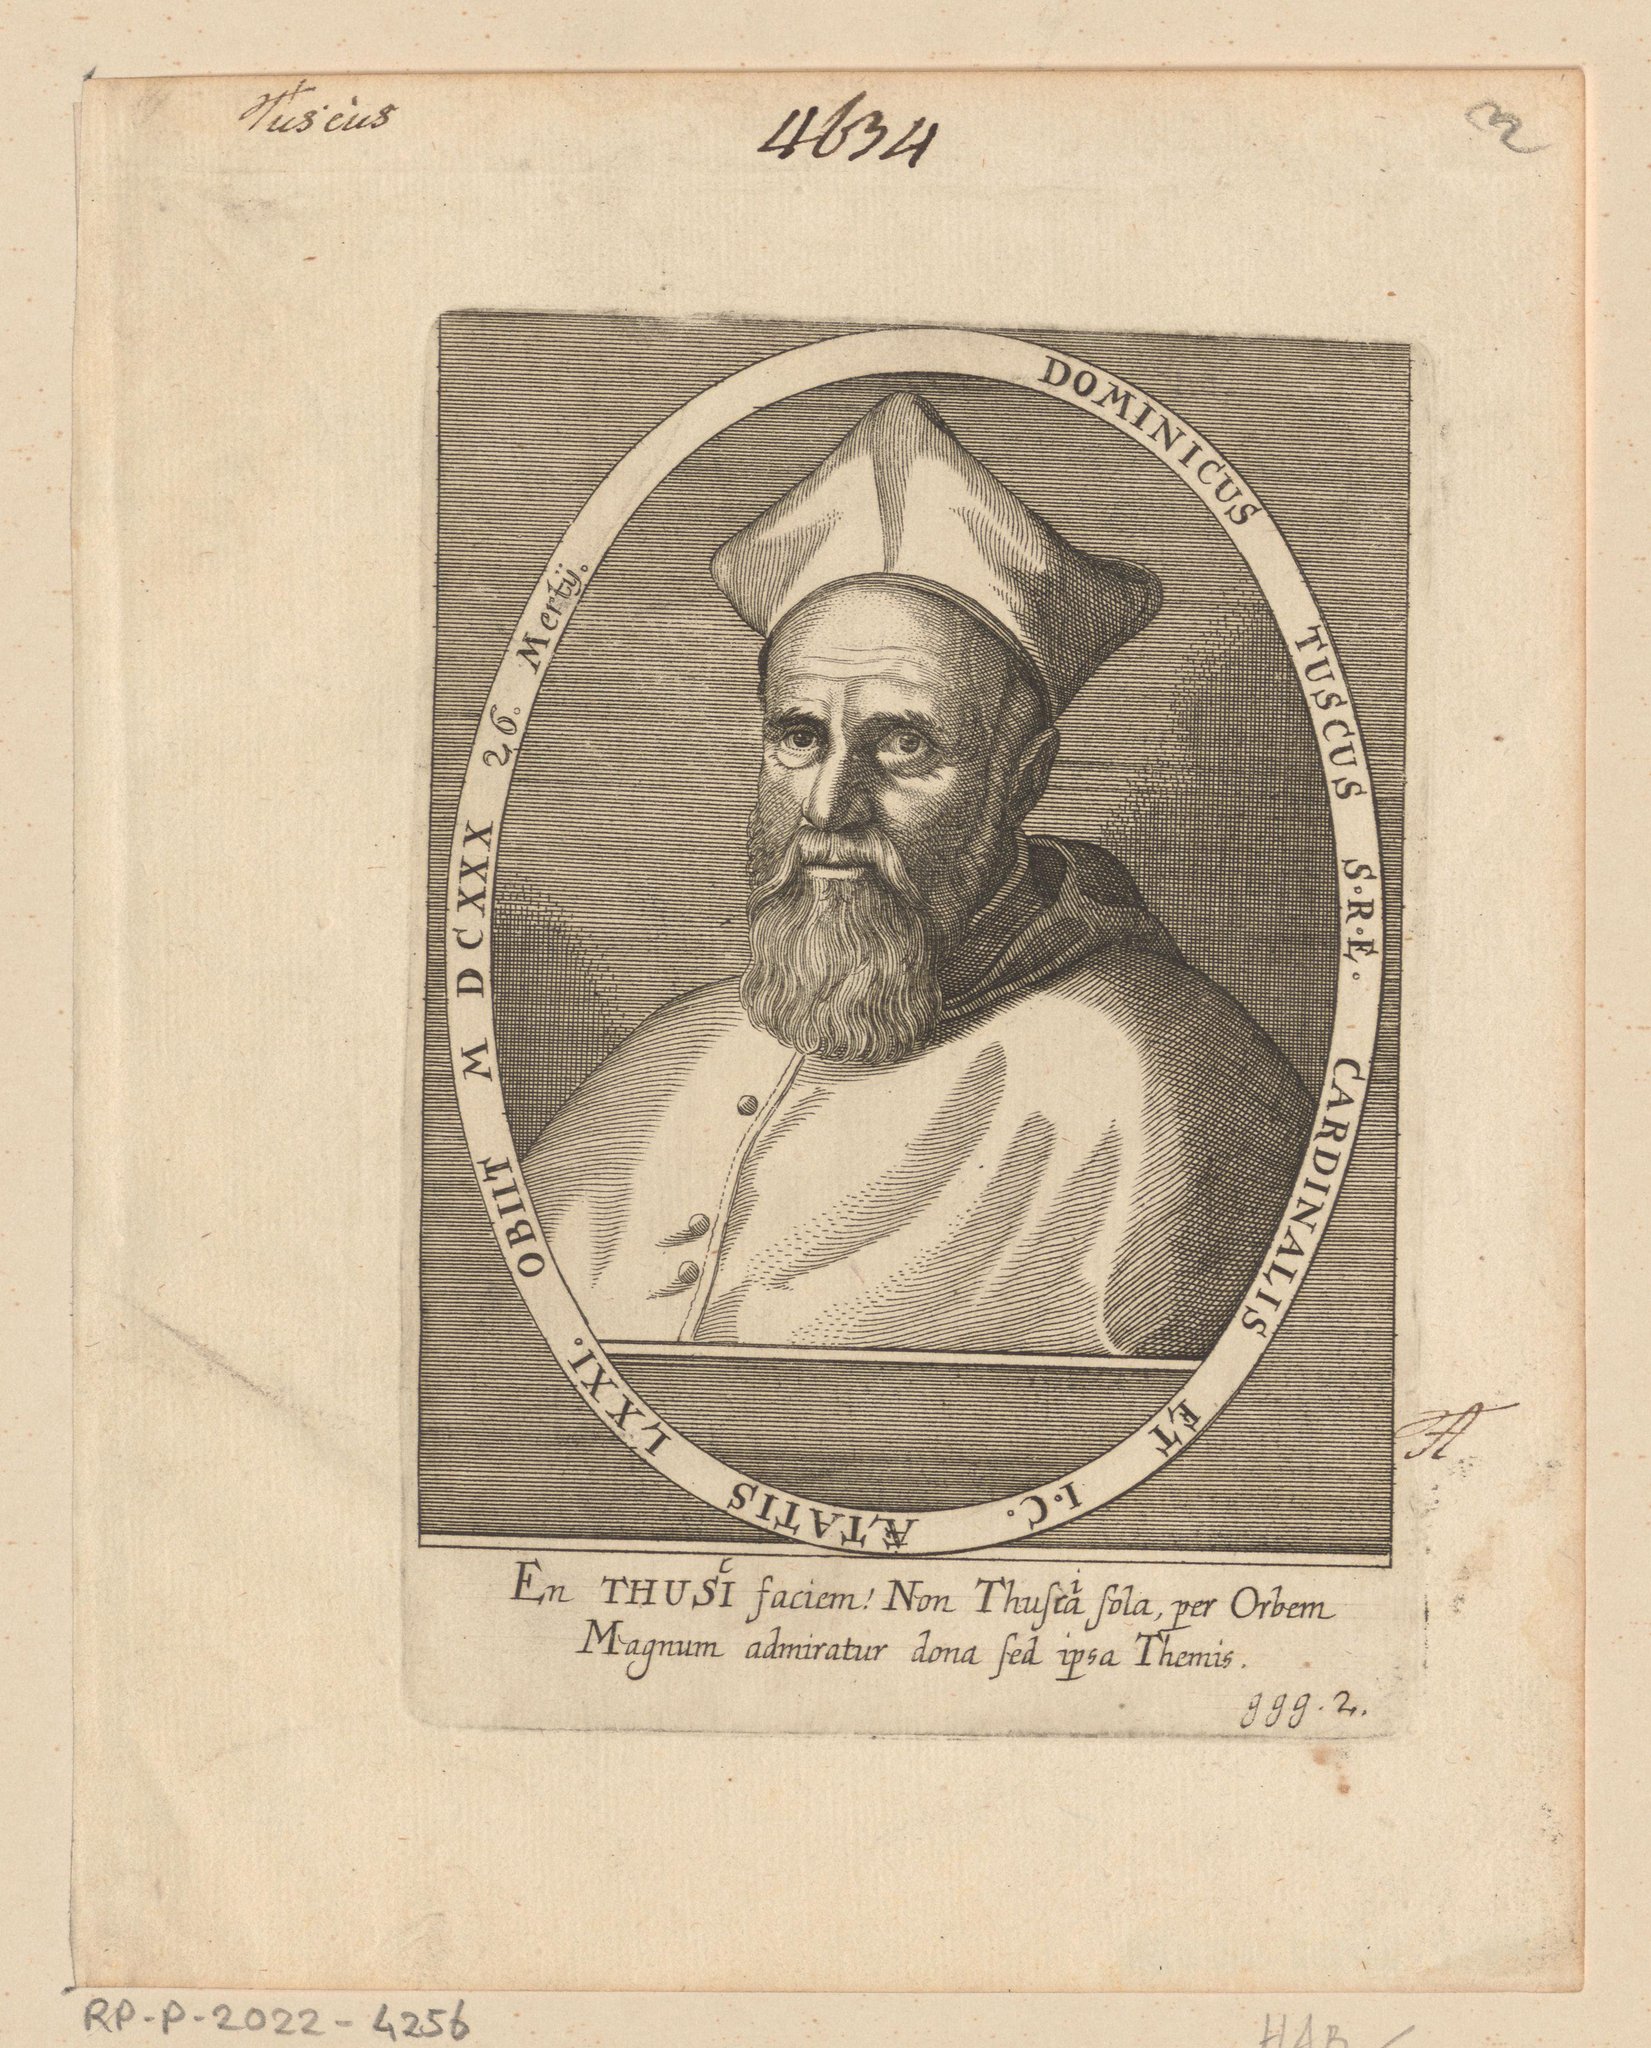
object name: print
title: Portret van Domenico Toschi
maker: clemens ammon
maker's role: print maker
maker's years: 1627-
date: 1652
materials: paper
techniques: engraving, etching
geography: germany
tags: cardinal, historical persons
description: Prent waarschijnlijk uit: Boissard, Jean Jacques. Bibliotheca chalcographica (...) VIII pars. Frankfurt am Main: Johannes Ammon, 1652.